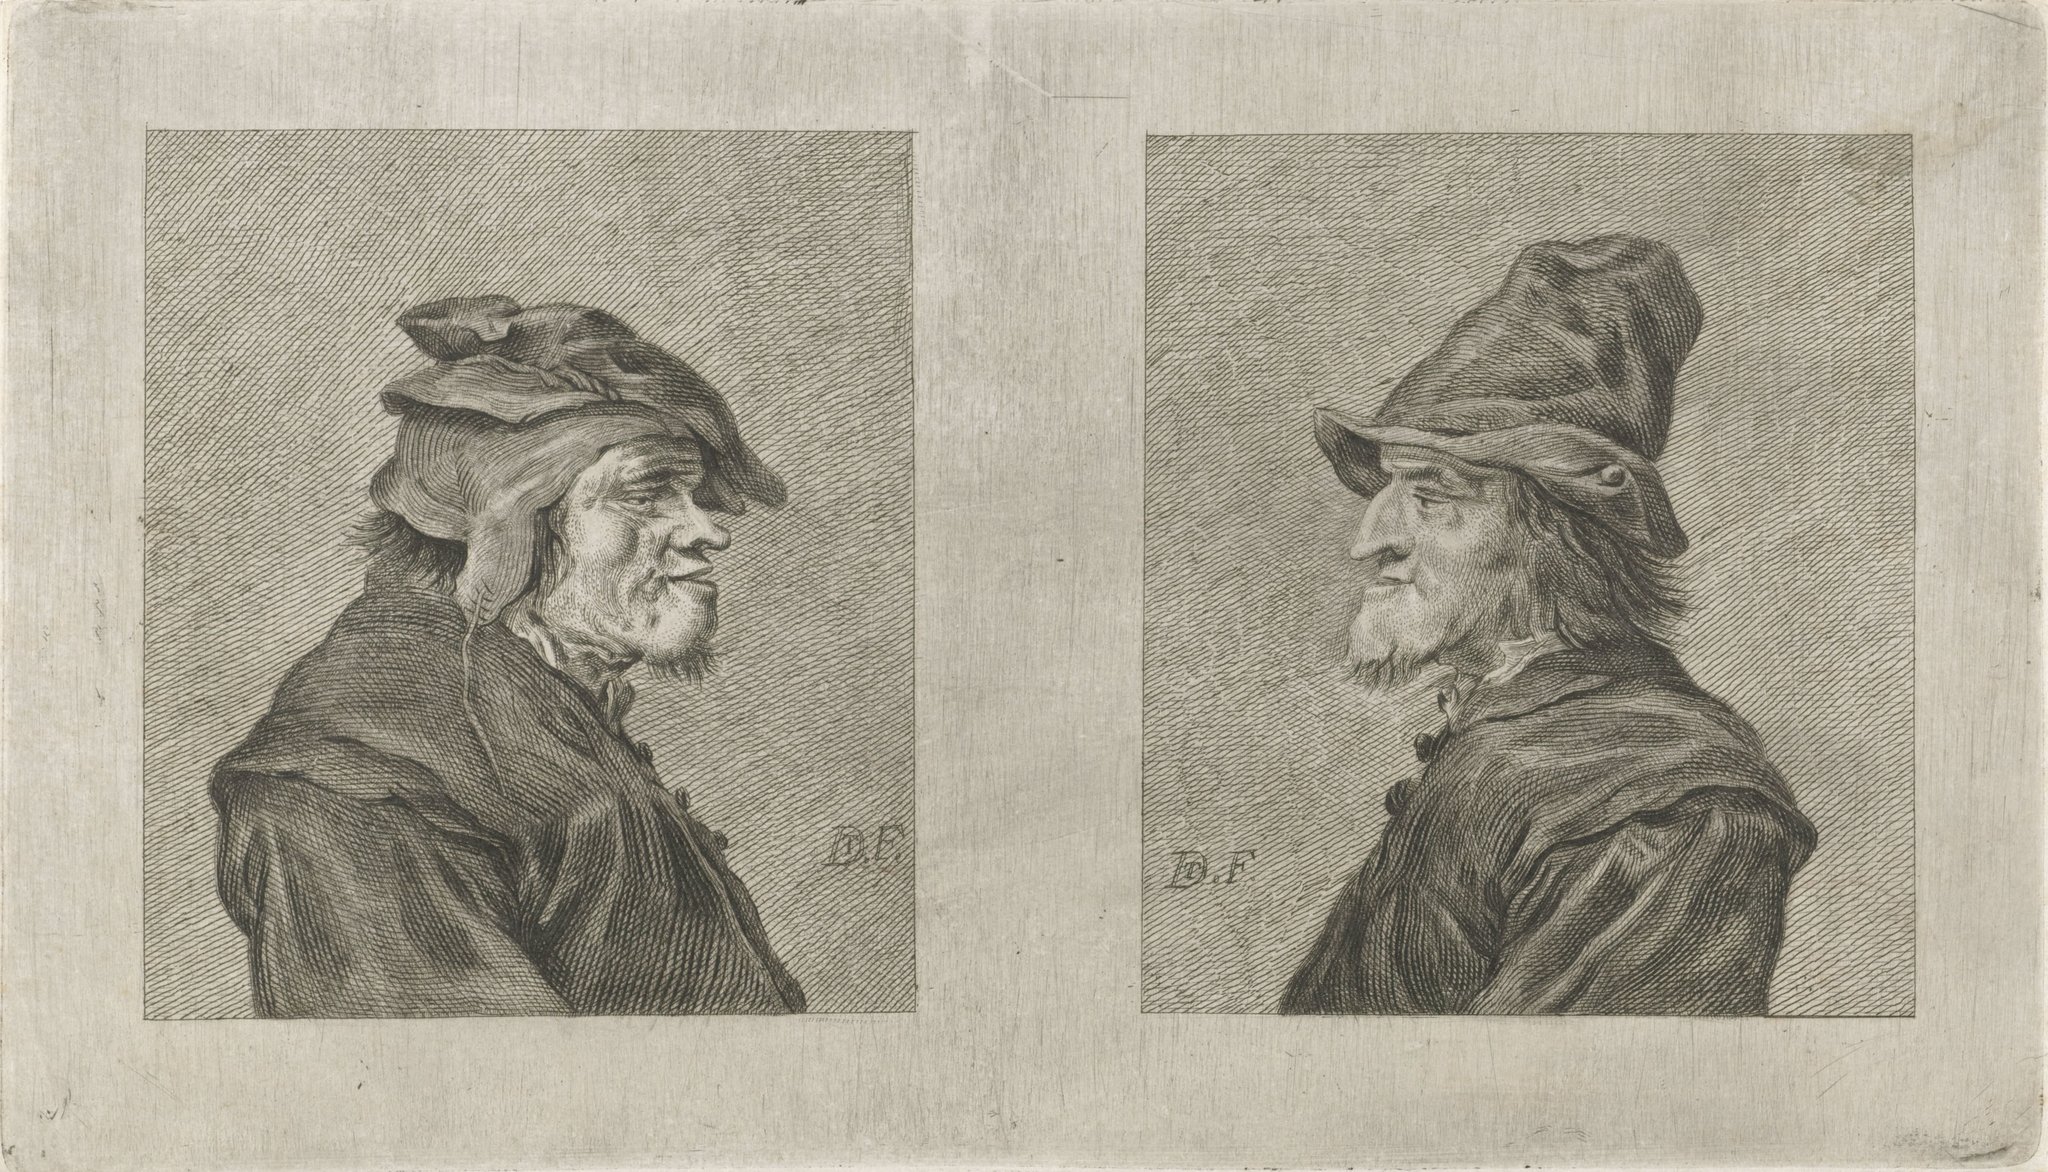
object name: print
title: Twee boerenkoppen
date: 1768-1796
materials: paper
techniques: engraving, etching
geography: leiden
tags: head (human), farmers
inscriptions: collector's mark: Lugt 240